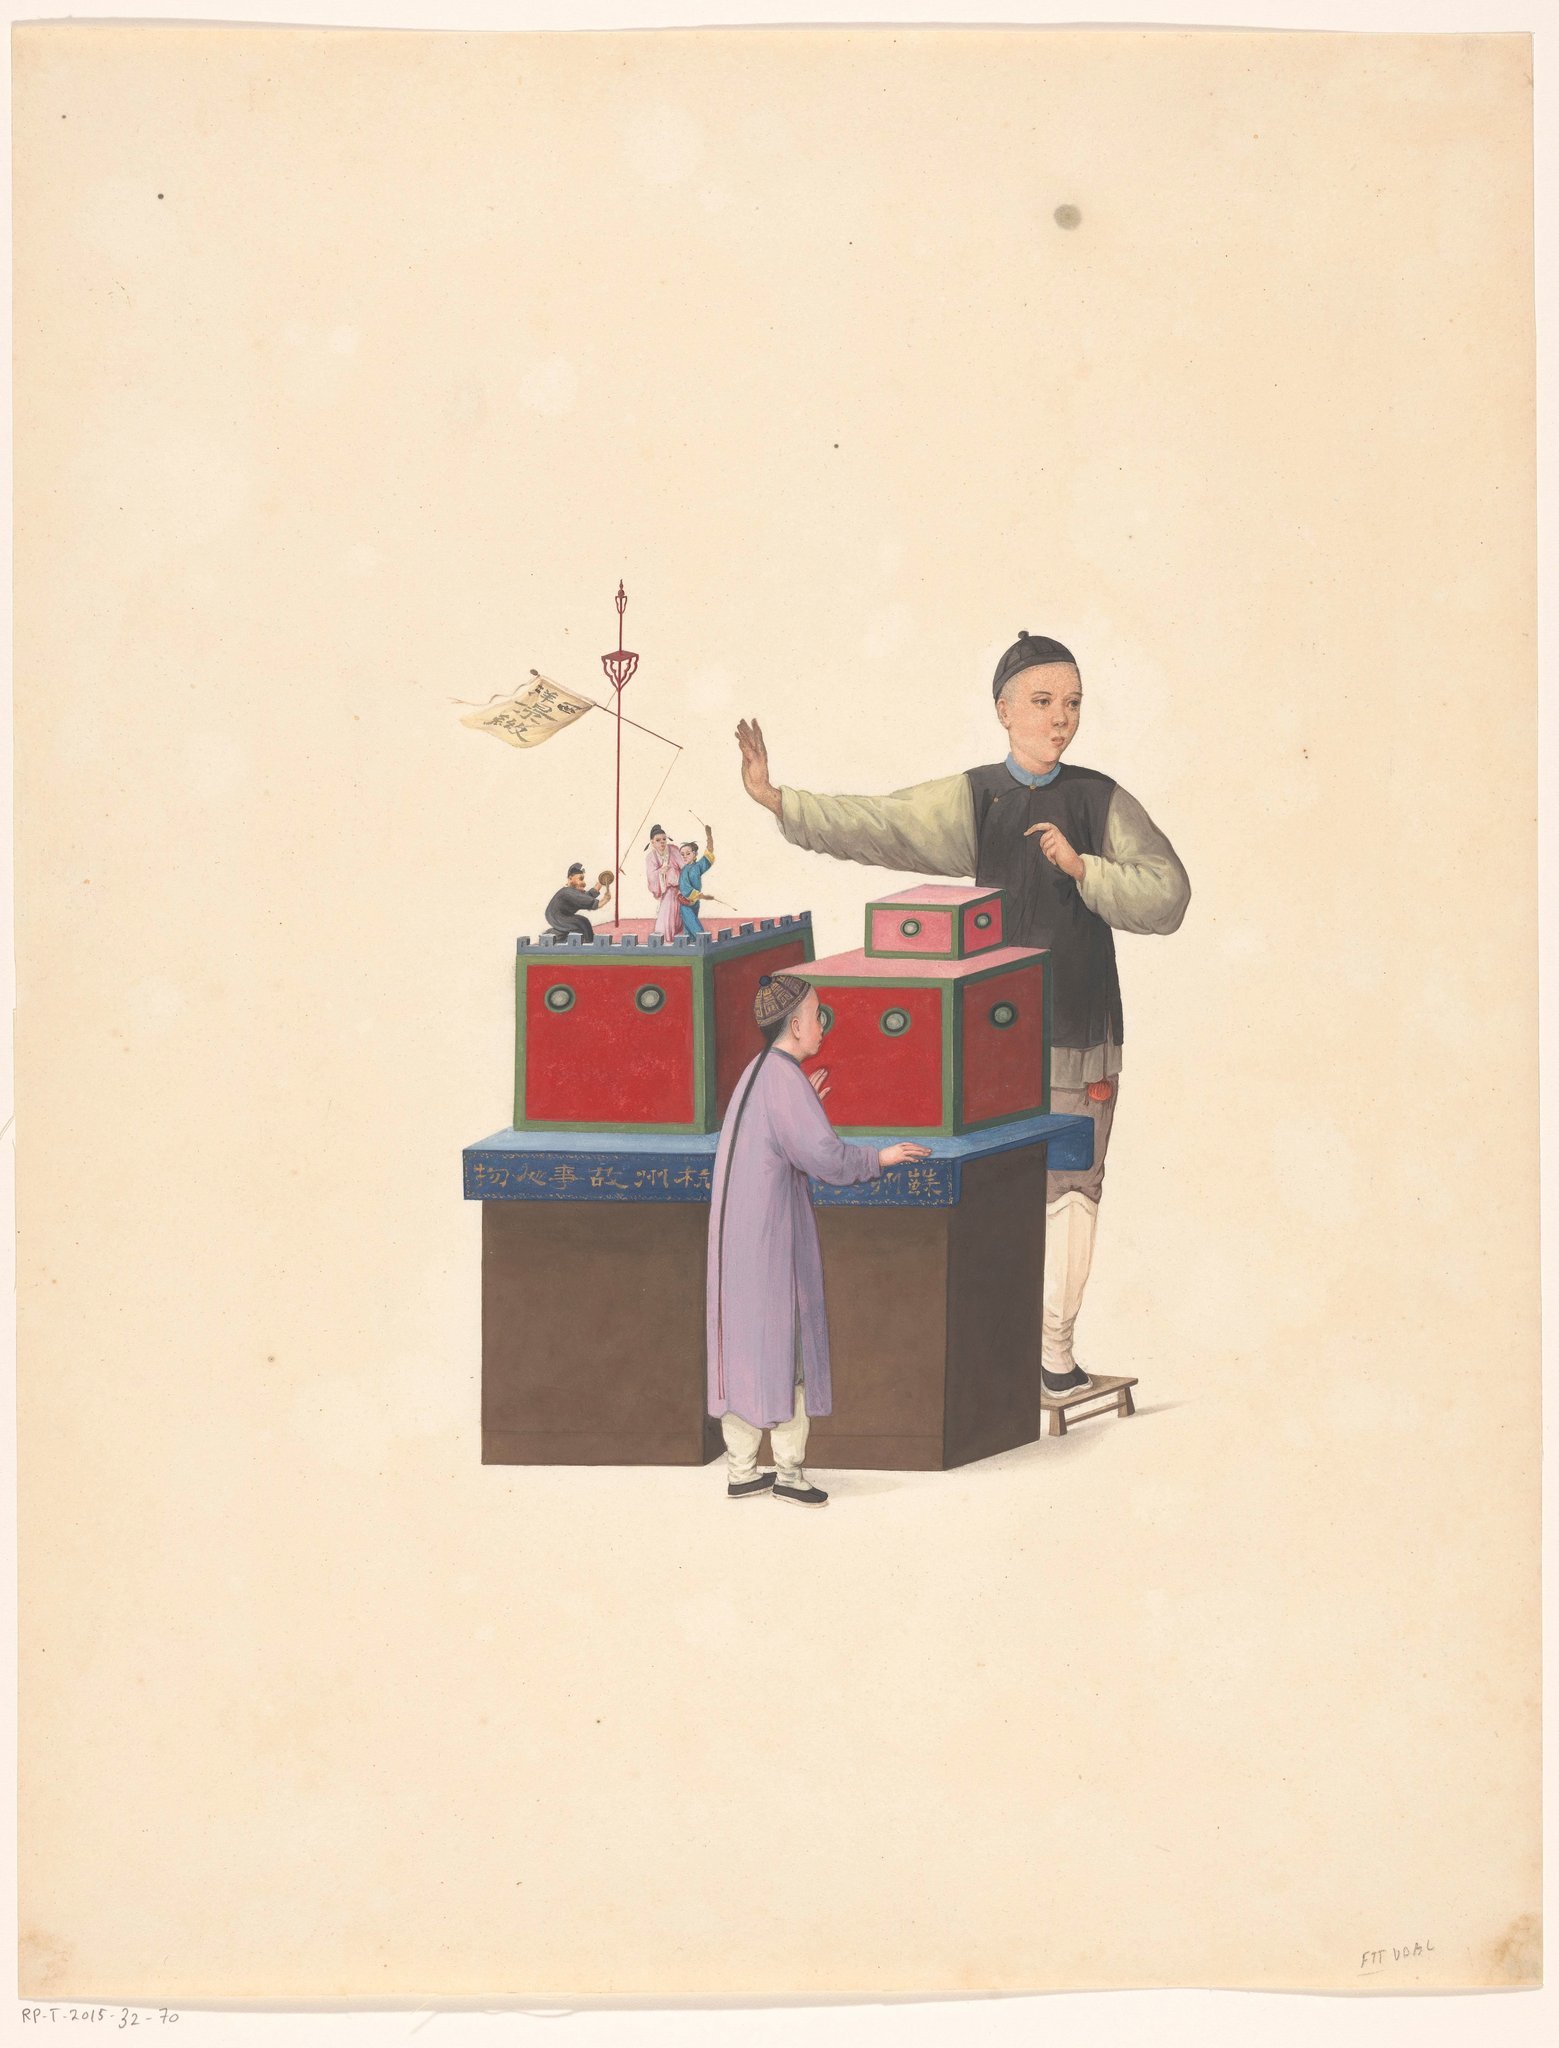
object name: drawing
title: Chinese kijkkast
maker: Anonymous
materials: paint, gold, paper, watercolor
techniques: brush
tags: chinese, peep-show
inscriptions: collector's mark: Lugt 2228, watermark: ‘J Whatman 1805’, collector's mark: Lugt 4779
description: Op een tafel met een rand met Chinese karakters staan twee kijkkasten met elk twee kijkgaten. Op de linker kast staan drie figuren die muziek maken en dansen naast een mast waaraan een vlag met Chinese karakters is bevestigd. Achter de tafel staat de eigenaar van de kijkkasten op een verhoging. Op de voorgrond een jongen met een lange vlecht die door een gat in de rechter kijkkast kijkt.